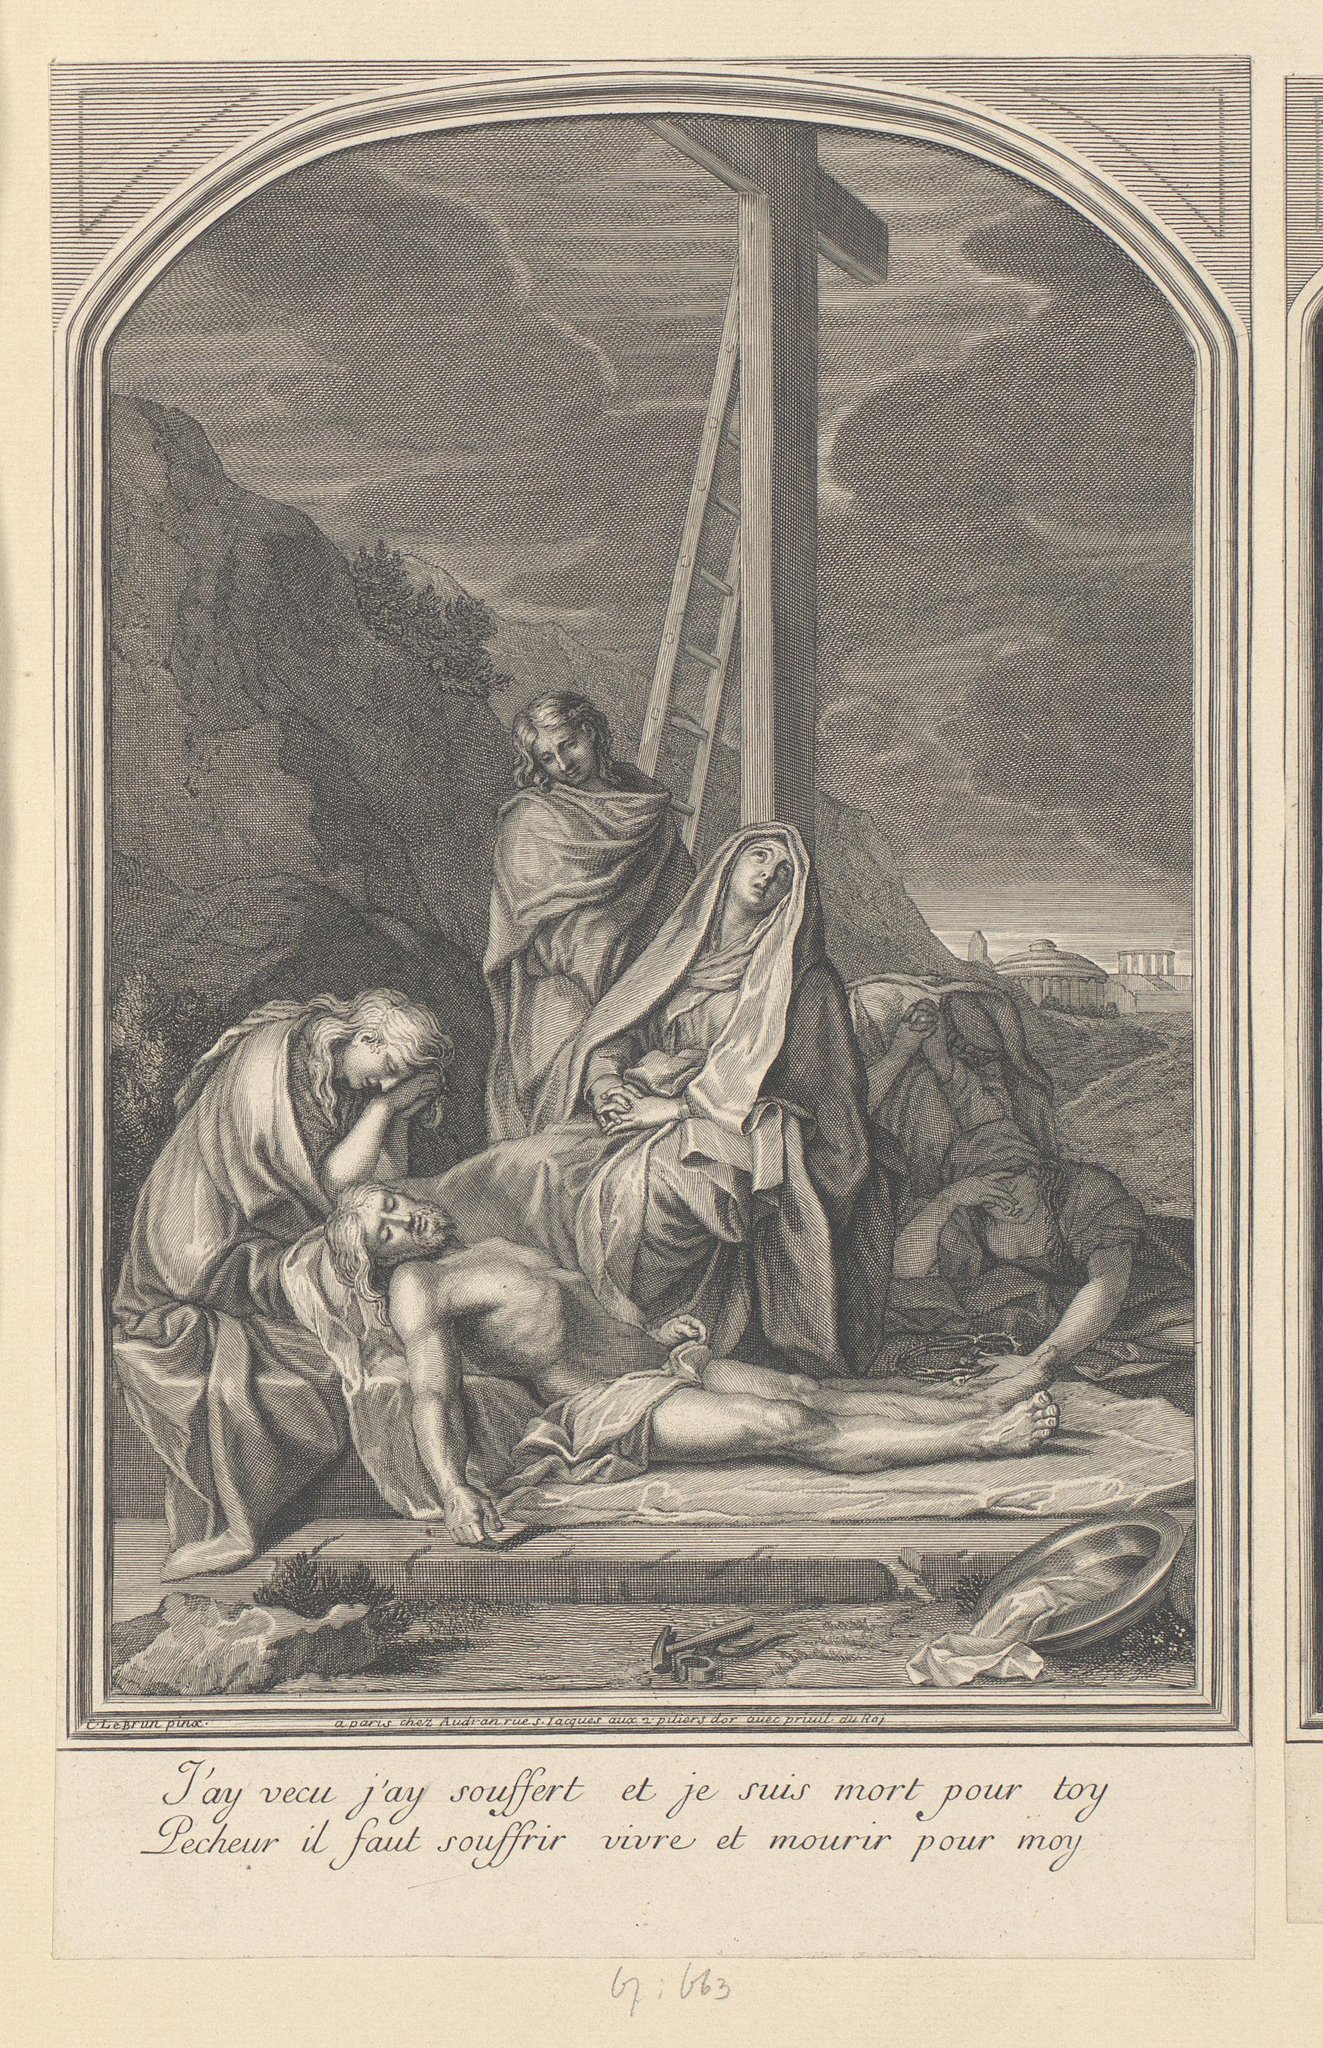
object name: print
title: Bewening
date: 1620-1686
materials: paper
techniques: engraving, etching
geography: paris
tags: lamentation over the dead christ by his relatives and friends (christ usually without crown of thorns)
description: Deze prent maakt deel uit van een album.